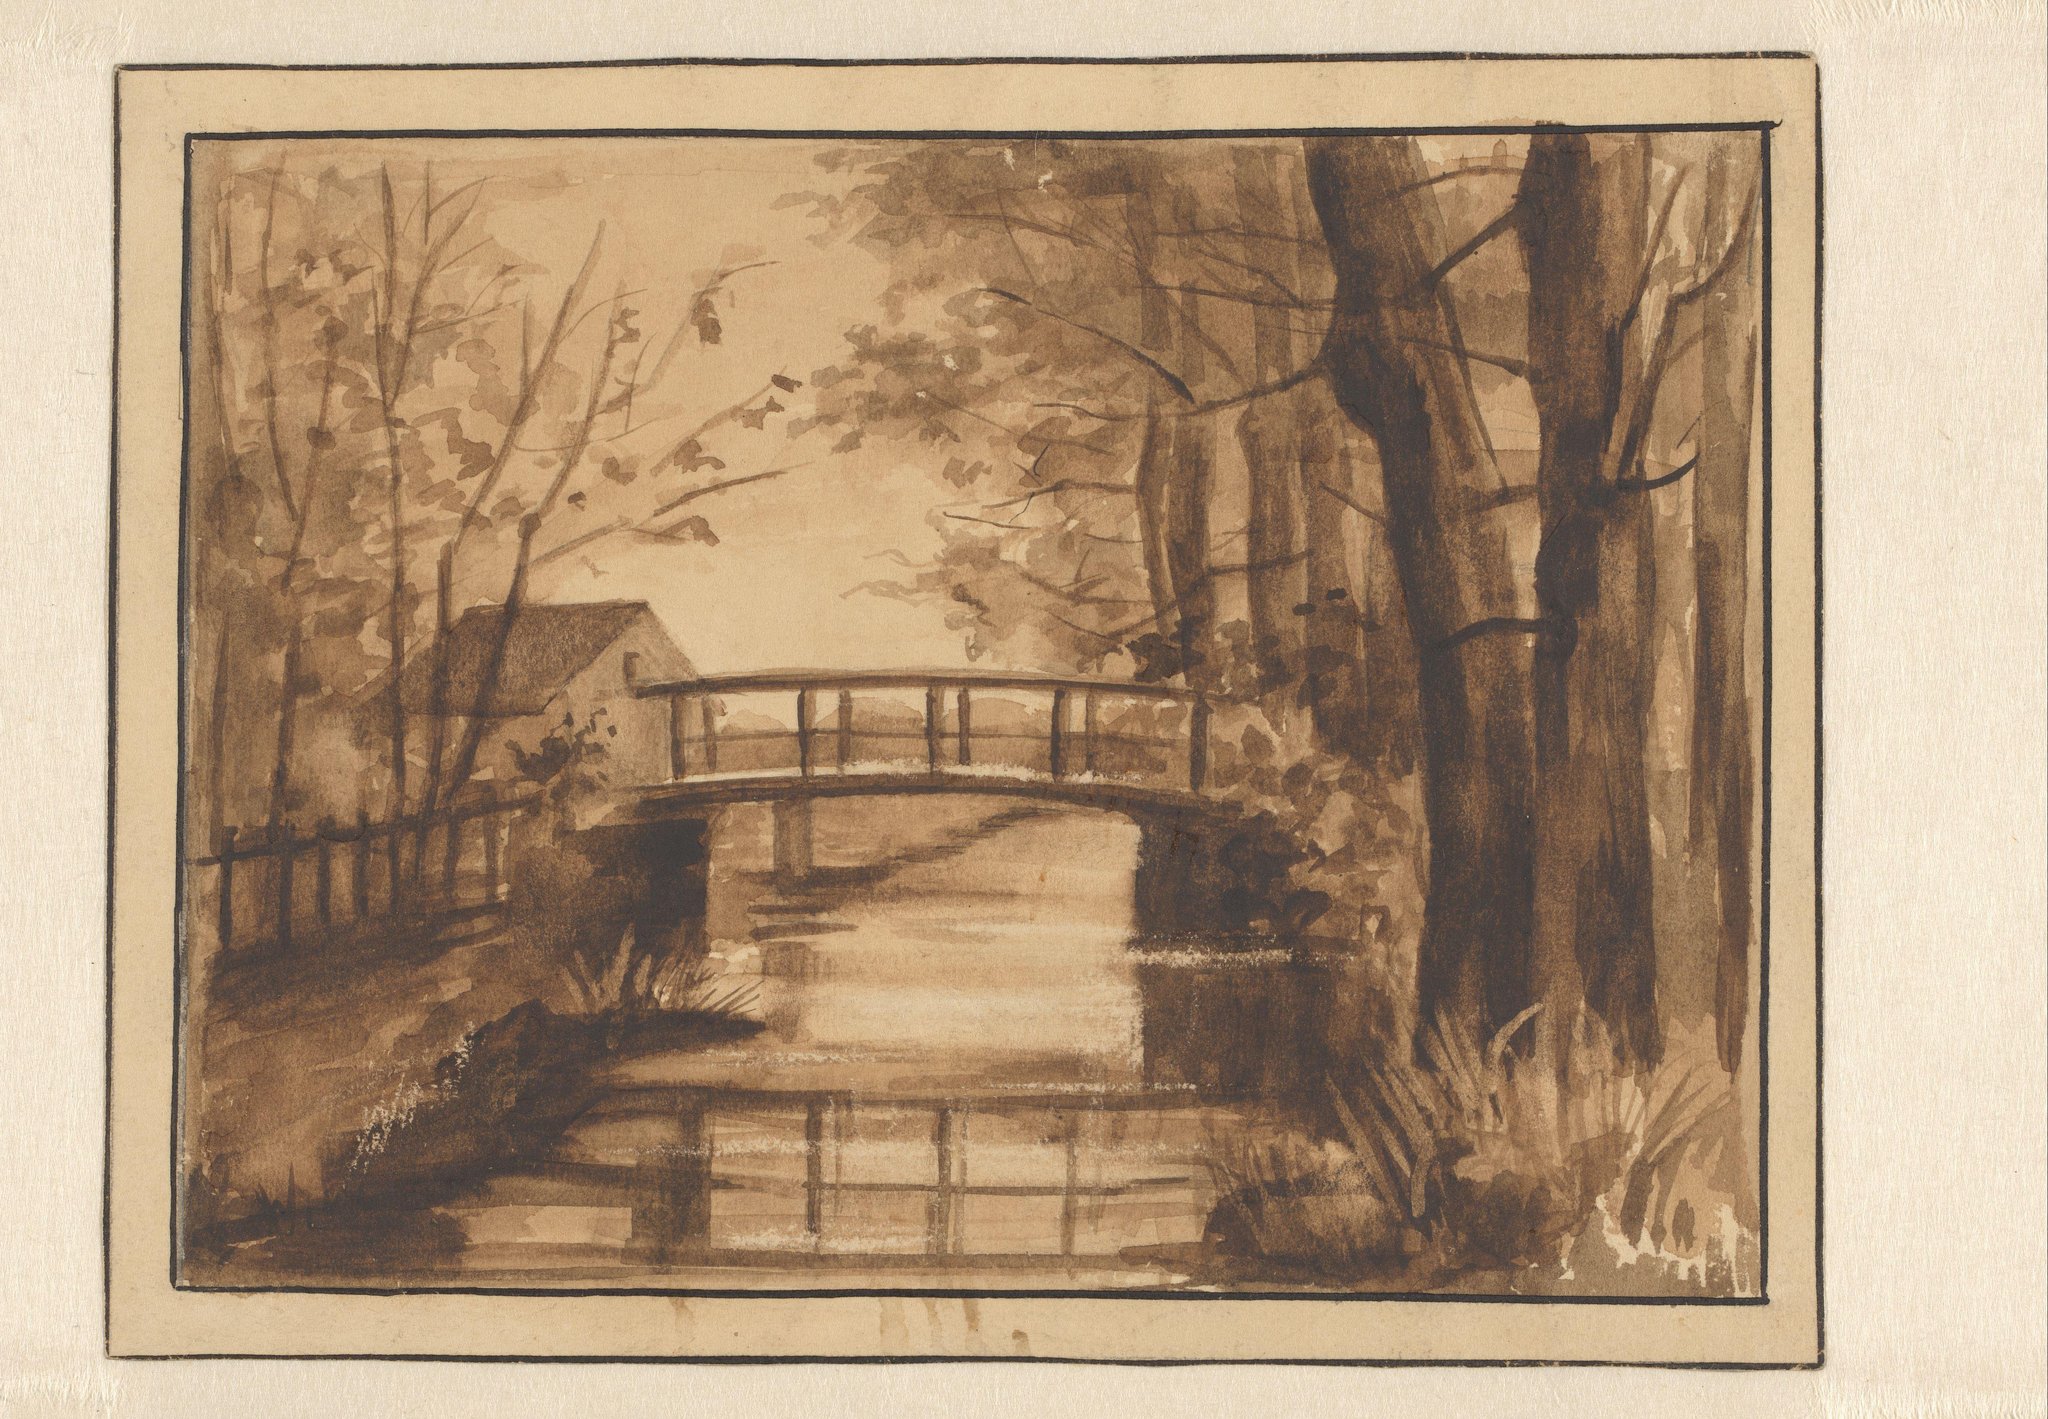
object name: drawing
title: Bruggetje over een sloot langs een bosrand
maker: willem witsen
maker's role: draughtsman, painter, print maker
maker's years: 1860-1923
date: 1870-1923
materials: paper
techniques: brush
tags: plants; vegetation, landscape with bridge, viaduct or aqueduct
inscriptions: number: ‘T 133’